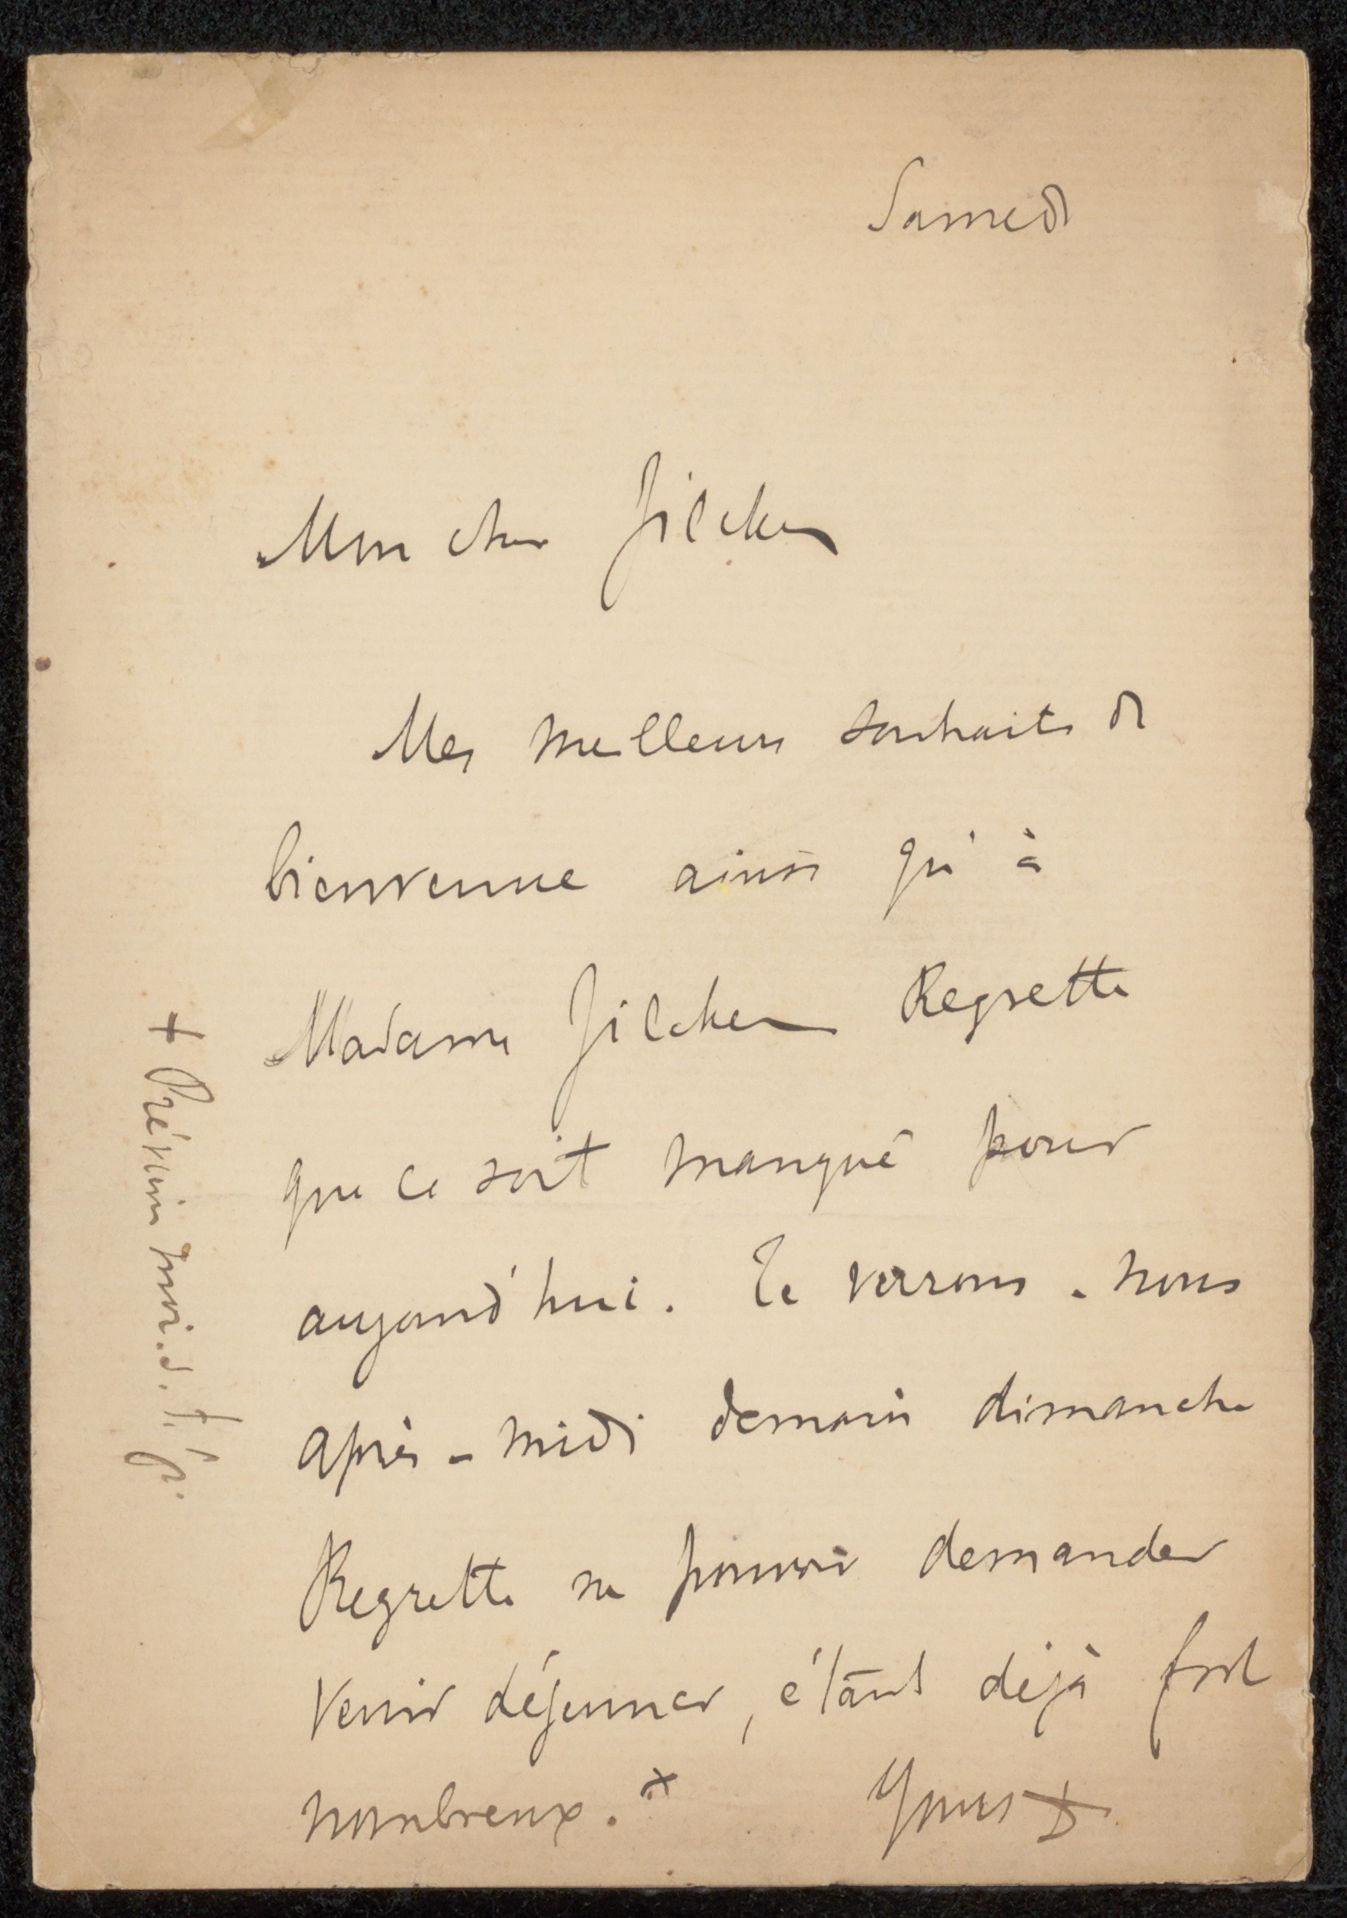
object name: letter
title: Brief aan Philip Zilcken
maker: charles destrée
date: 1867-1930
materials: ink, paper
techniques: pen, writing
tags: the hague, painter, draughtsman, philip zilcken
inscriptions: collector's mark: ‘RPK’